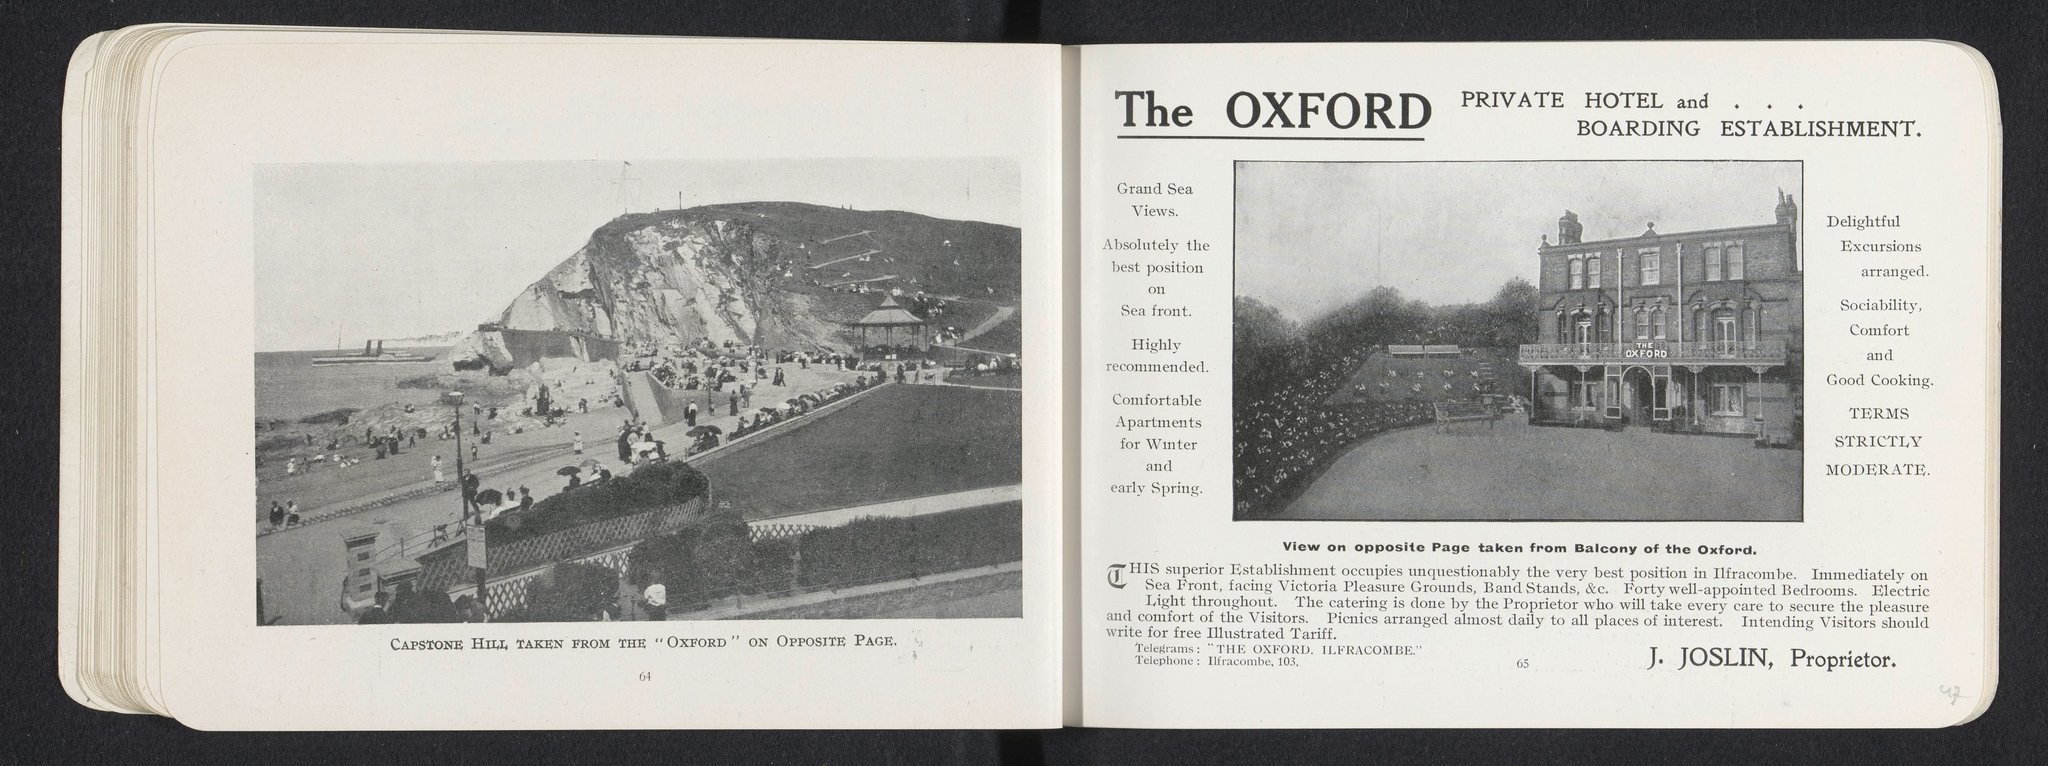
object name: photomechanical print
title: Capstone Hill taken from the "Oxford" on opposite page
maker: Anonymous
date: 1900-1920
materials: paper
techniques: autotype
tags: gulf, bay, (high) hill